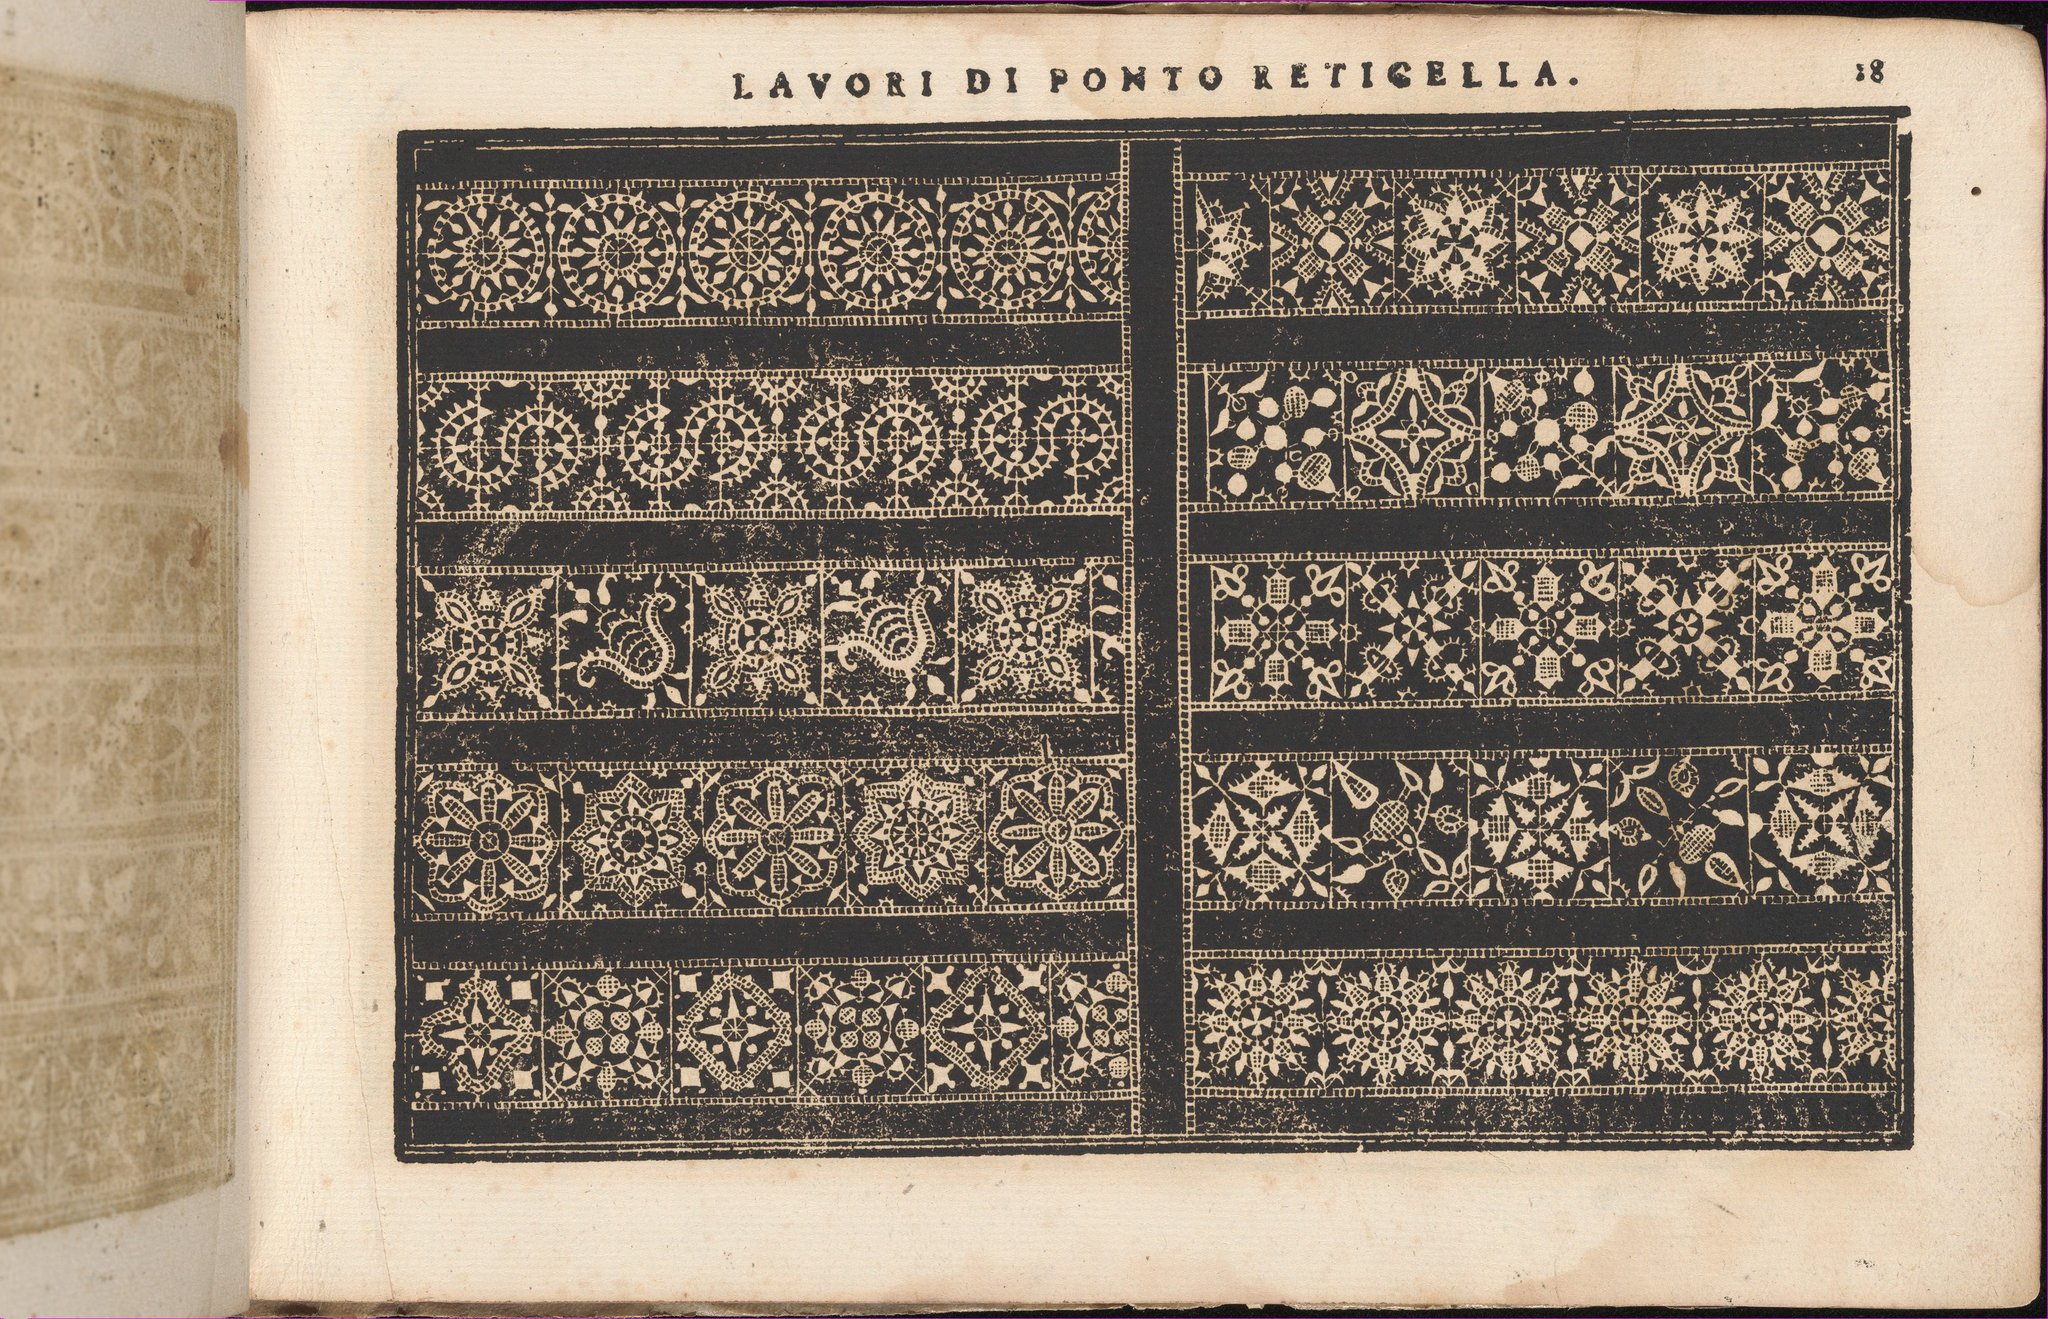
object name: book print ornament architecture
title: Teatro delle Nobili et Virtuose Donne..., page 16 (recto)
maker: isabella catanea parasole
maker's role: author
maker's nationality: italian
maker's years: 1565-1625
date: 1616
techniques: engraving, woodcut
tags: ornament